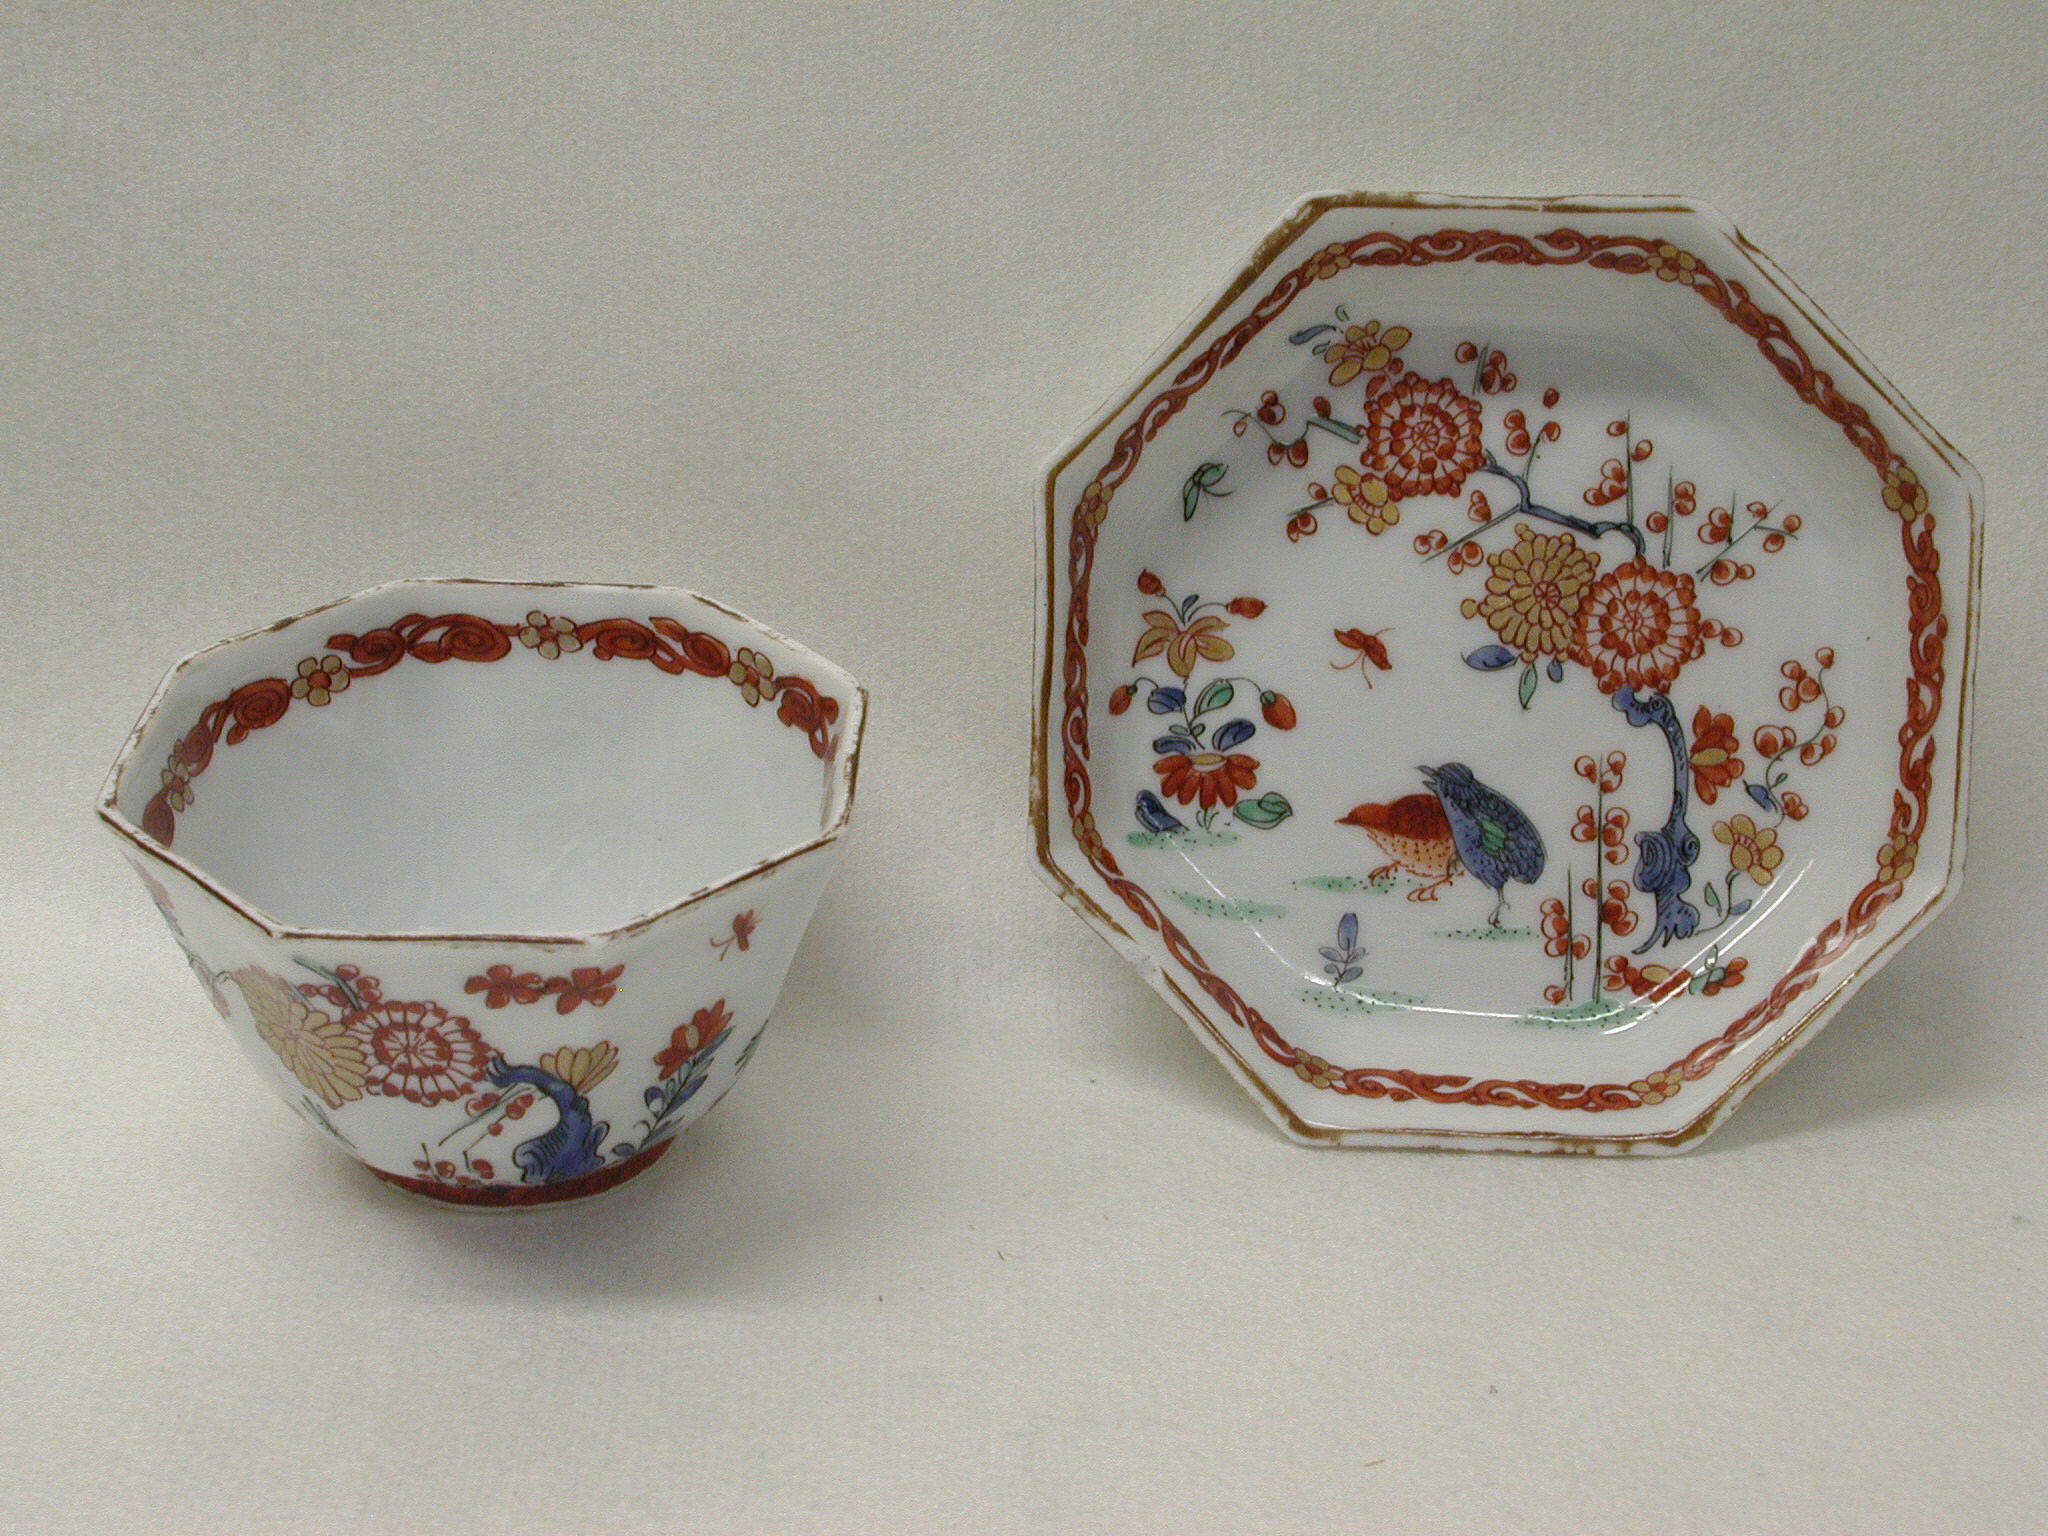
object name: cup and saucer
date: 1801-1900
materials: hard paste porcelain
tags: birds,flowers,plants